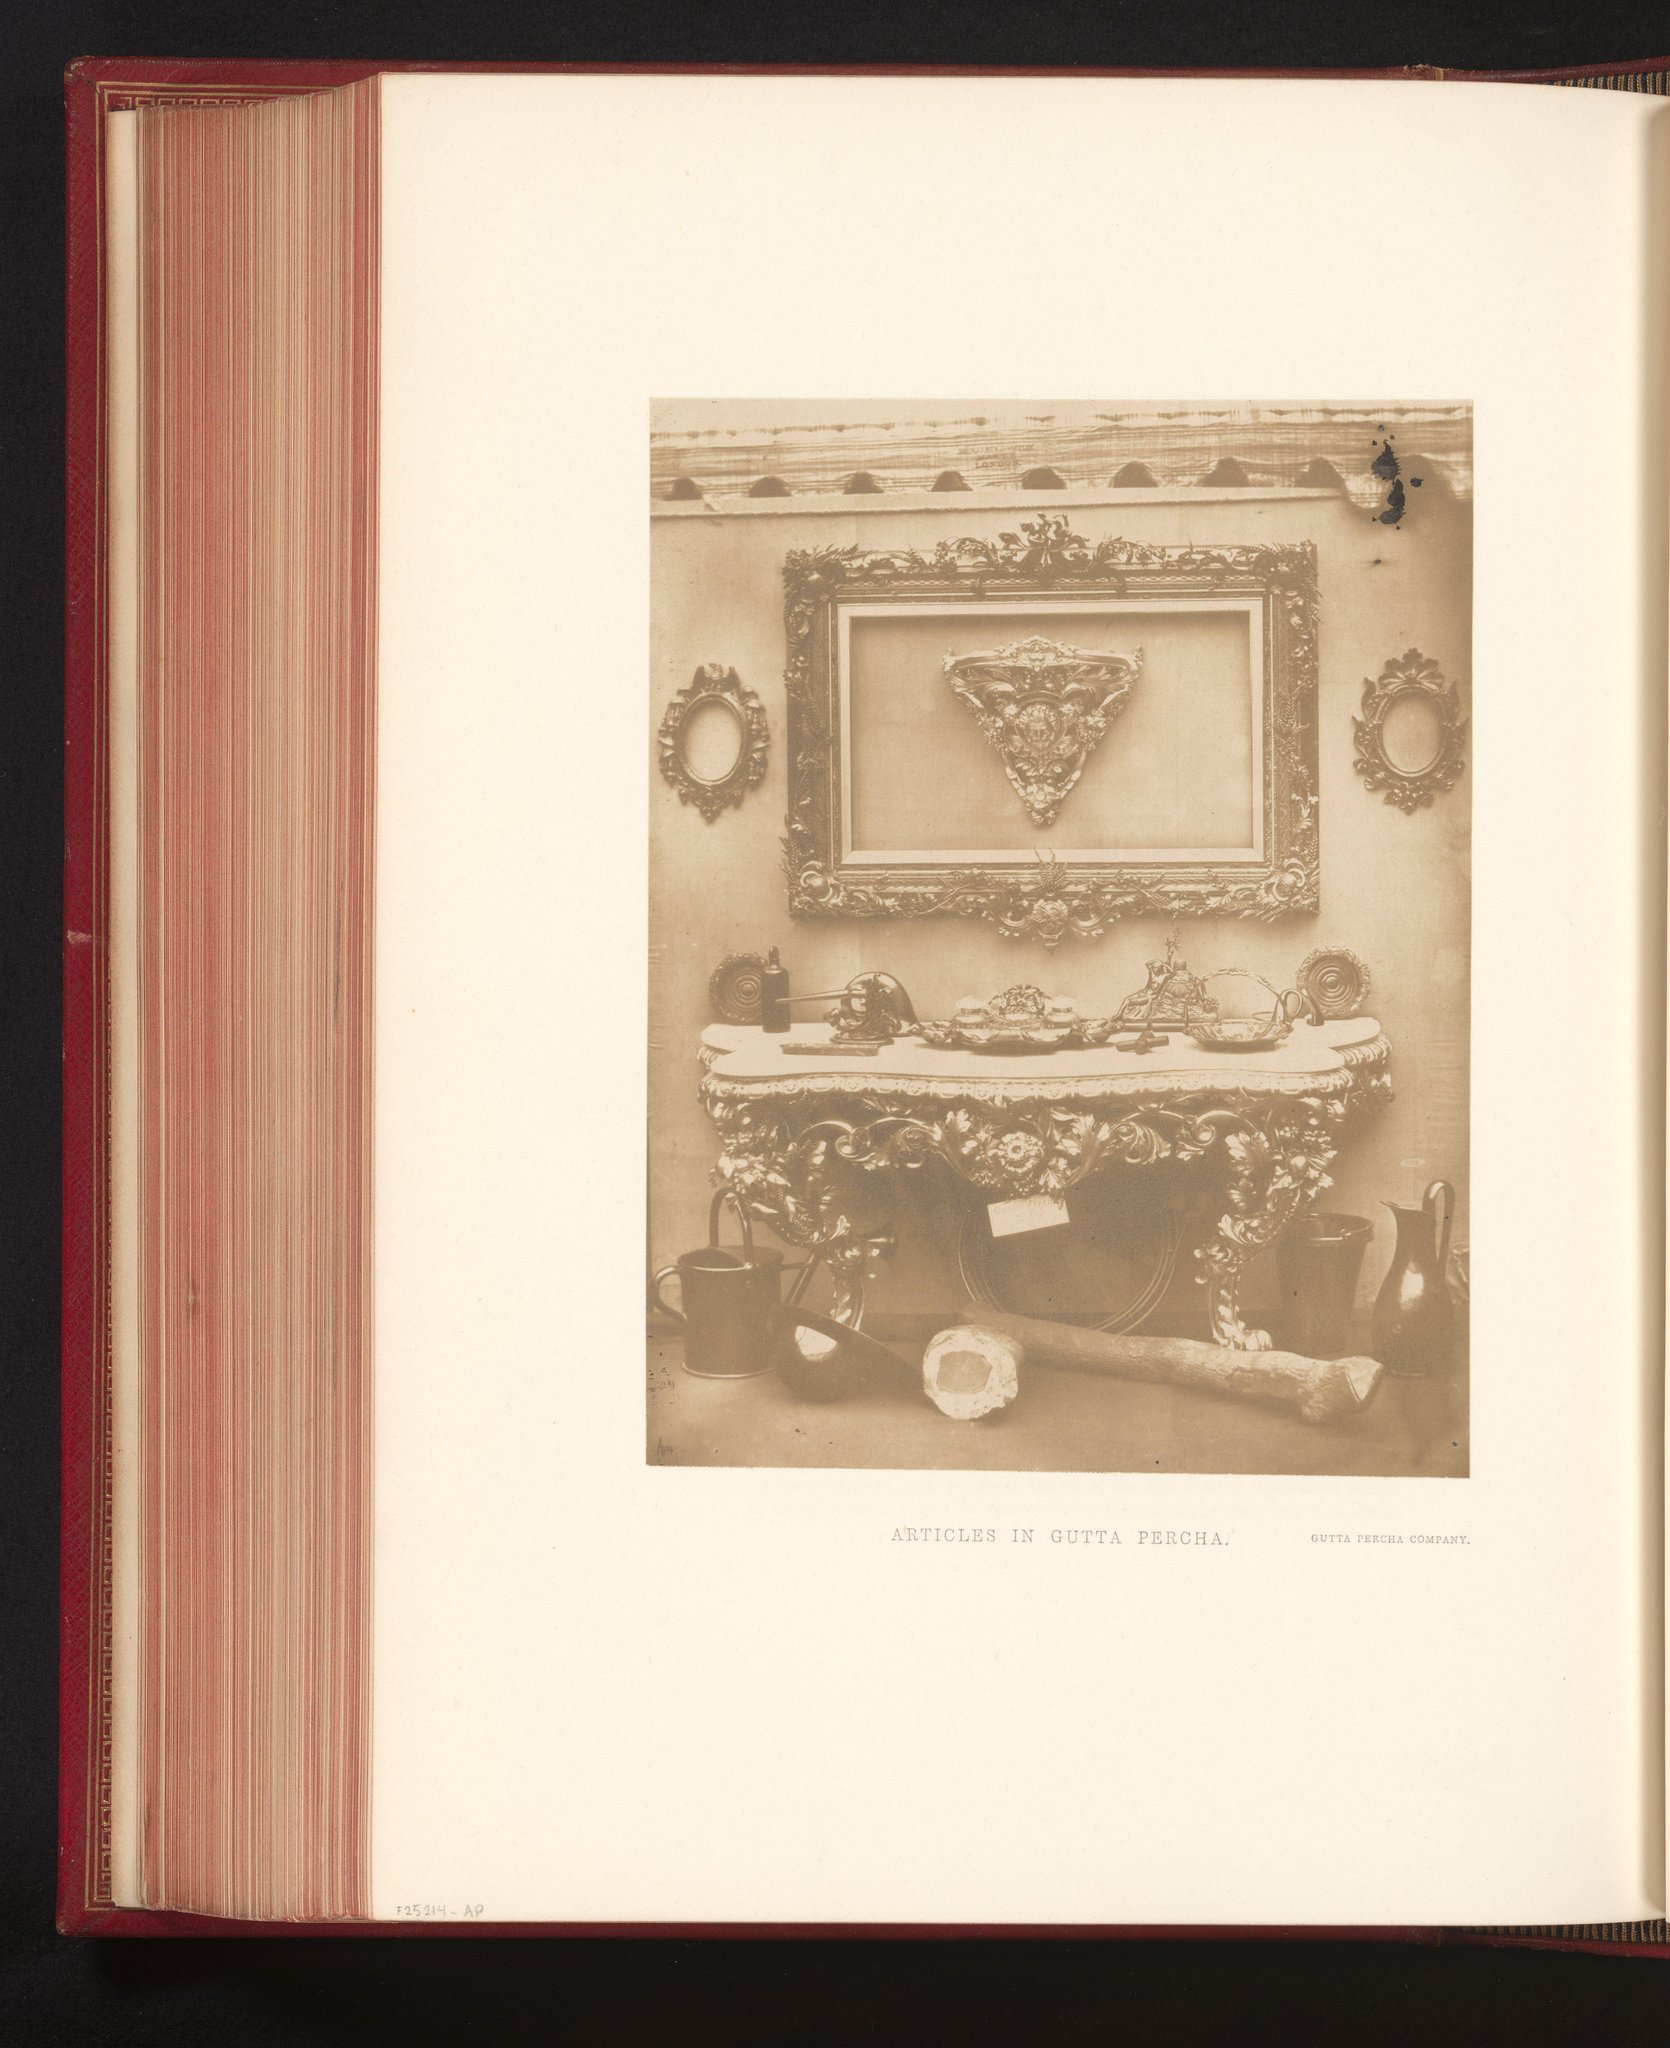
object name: page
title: Tafel, schilderijlijsten en andere producten gemaakt van Guttapercha op de Great Exhibition of the Works of Industry of All Nations van 1851 in Londen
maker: Anonymous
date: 1851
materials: photographic support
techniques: salted paper print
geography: london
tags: table, frame of painting, etc., london